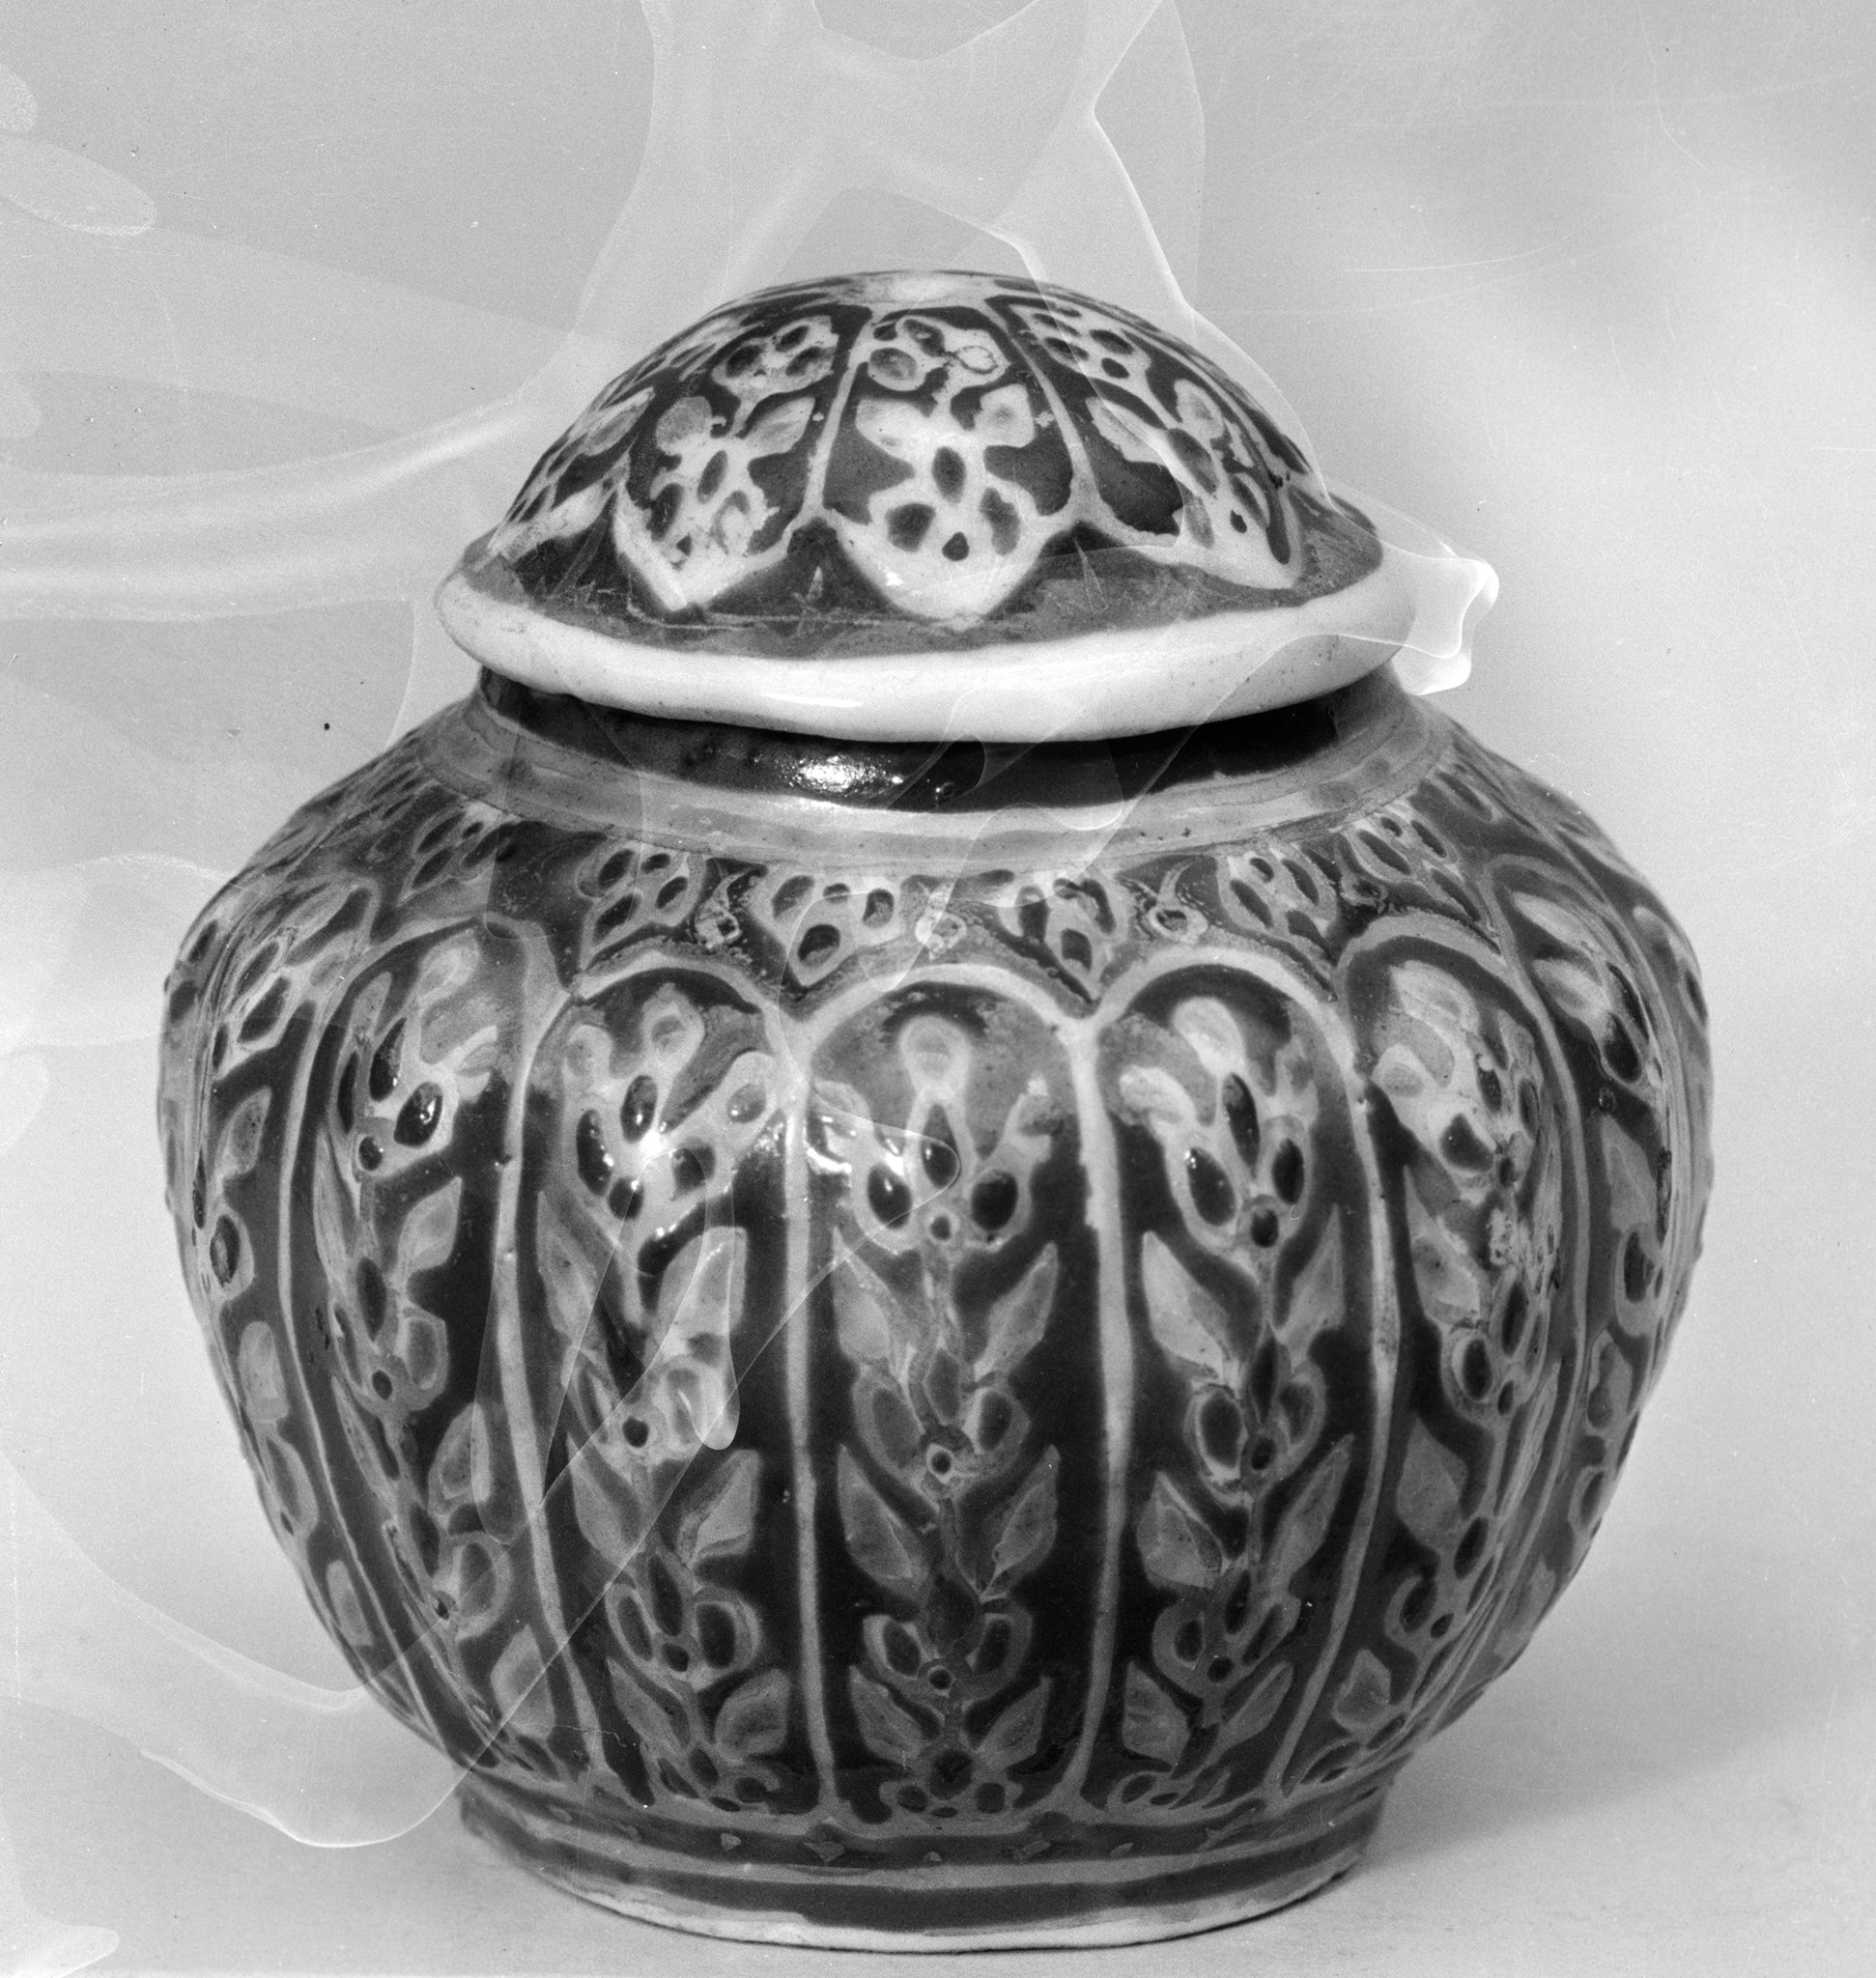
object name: covered jar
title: Covered jar with floral pattern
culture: chinese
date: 1801-1900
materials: enamel, porcelain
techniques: overglaze, painting, polychrome